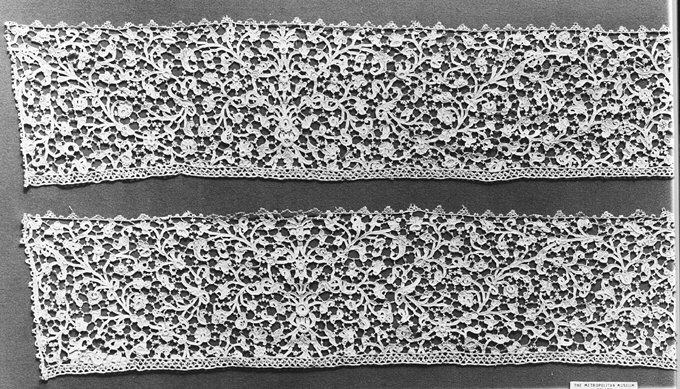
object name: fragment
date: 1601-1700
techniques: lace